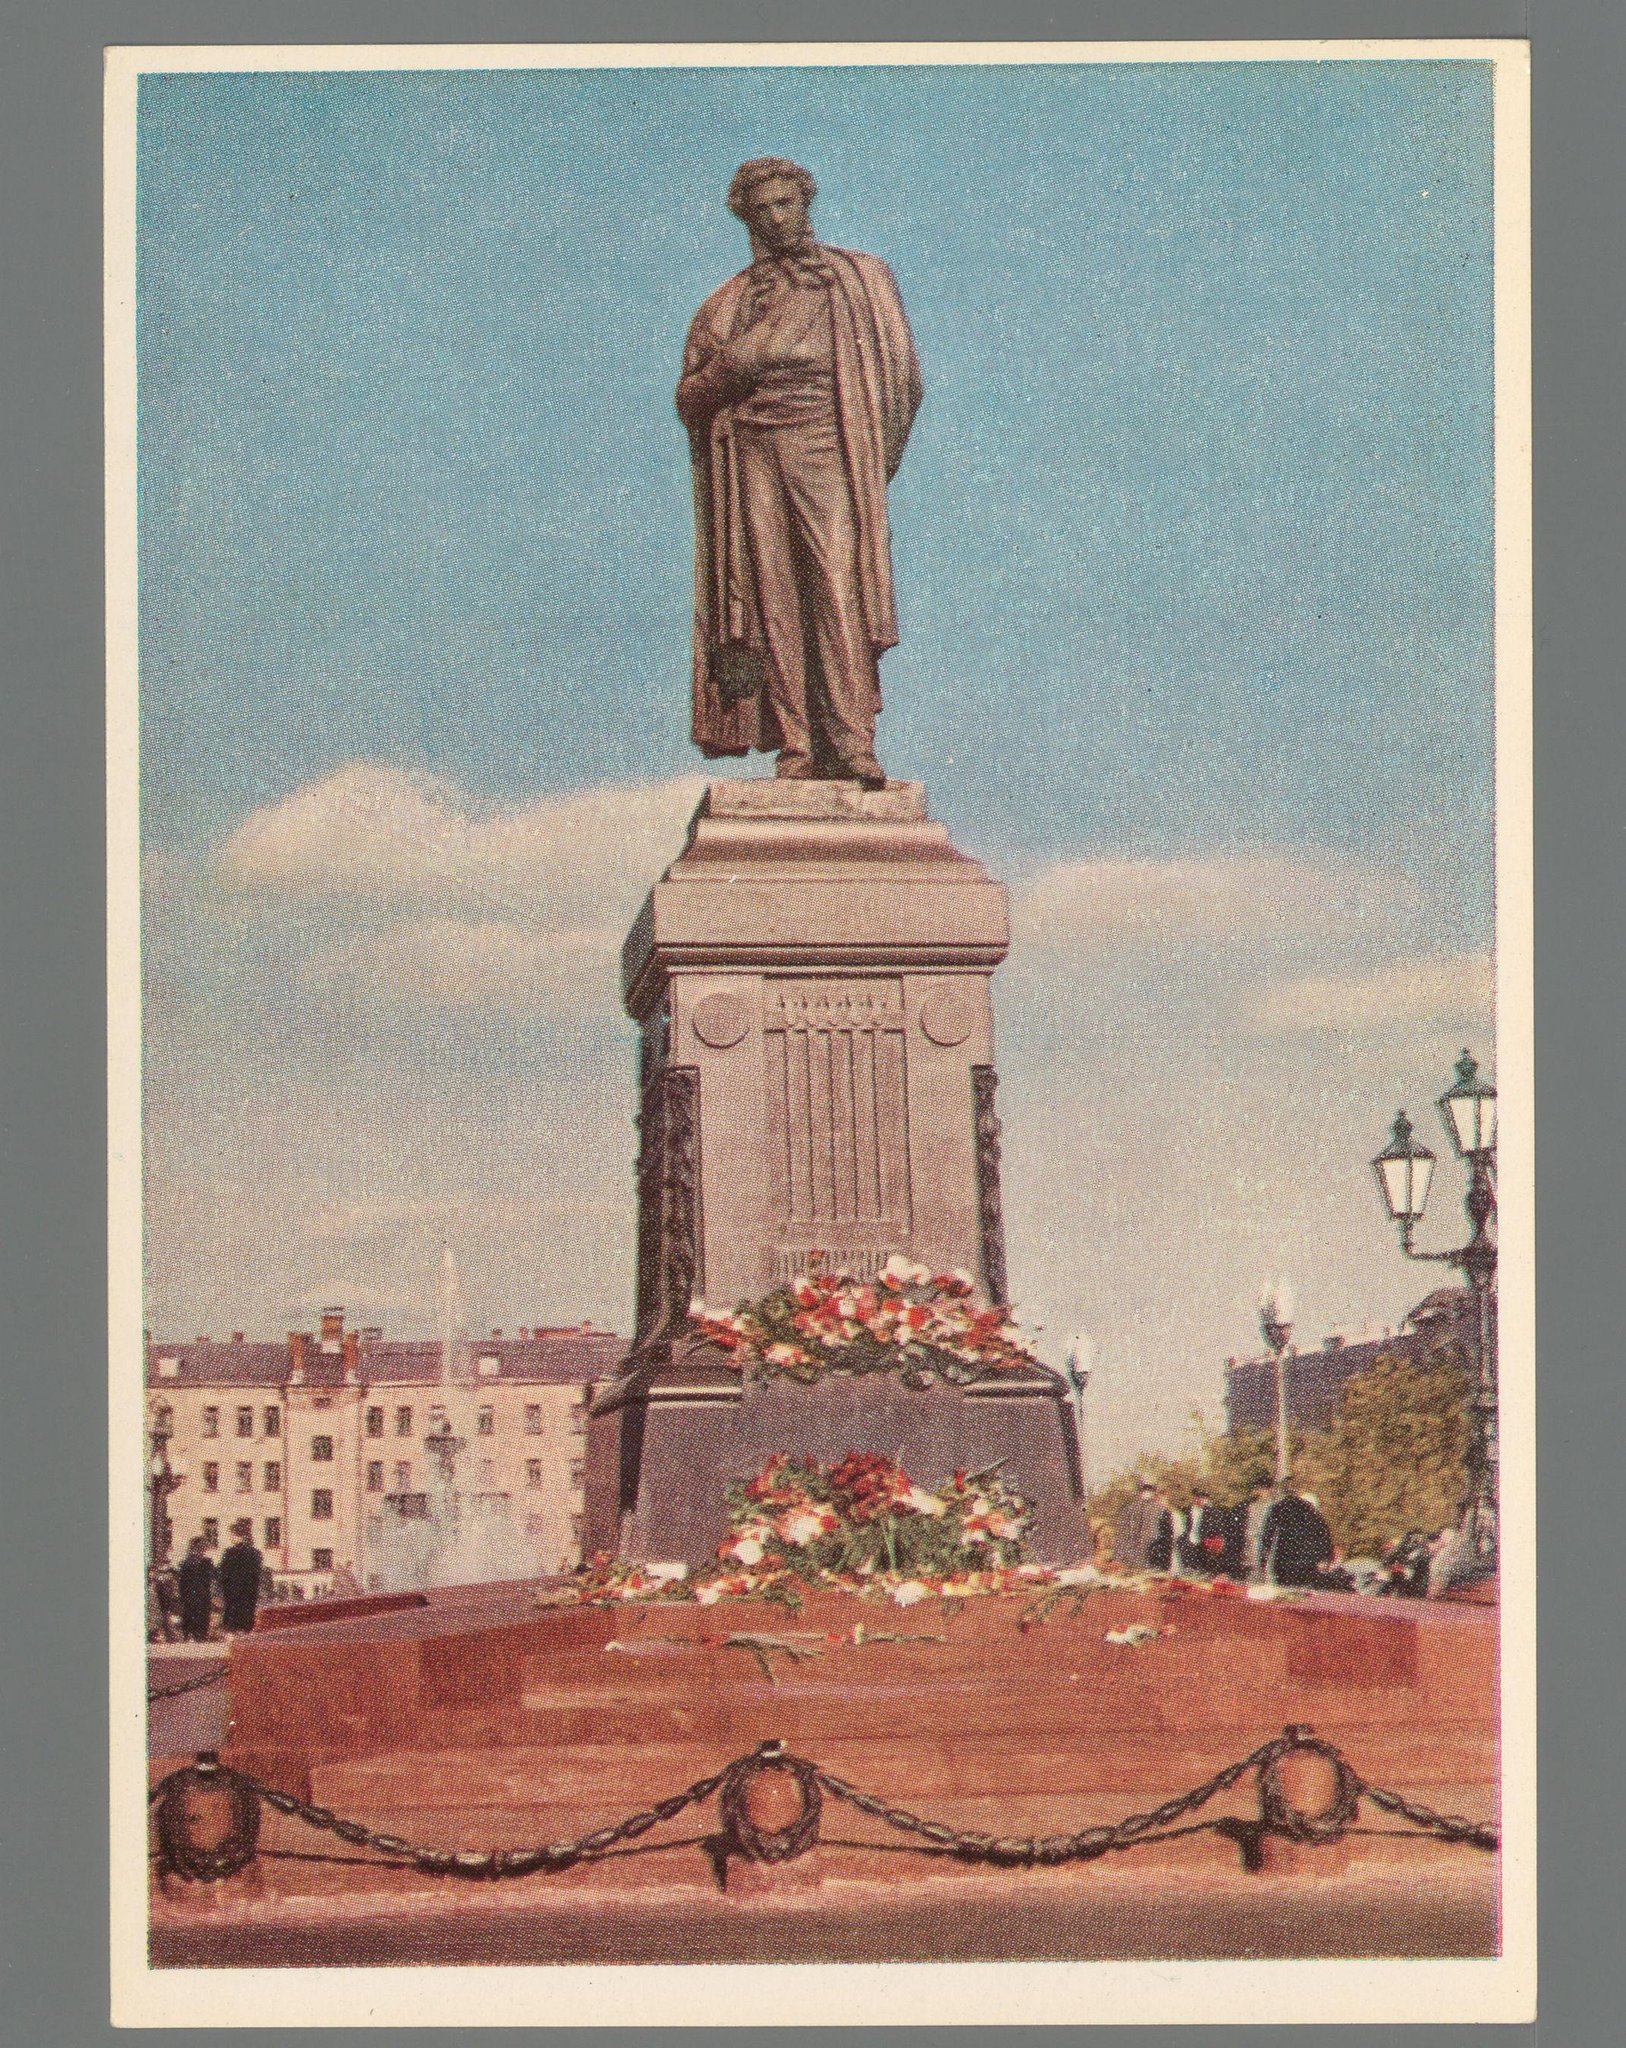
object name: photomechanical print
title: Moscow. Pushkin Monument / Moskau. Denkmal des groβen russischen Dichters A.S. Puschkin / Moscou. Monument de Pouchkine, grand poète russe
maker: Anonymous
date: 1956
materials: cardboard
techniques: color autotype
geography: moscow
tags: aleksandr sergeevic puskin, monument, statue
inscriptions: date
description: De titel op object staat ook in het Russisch.